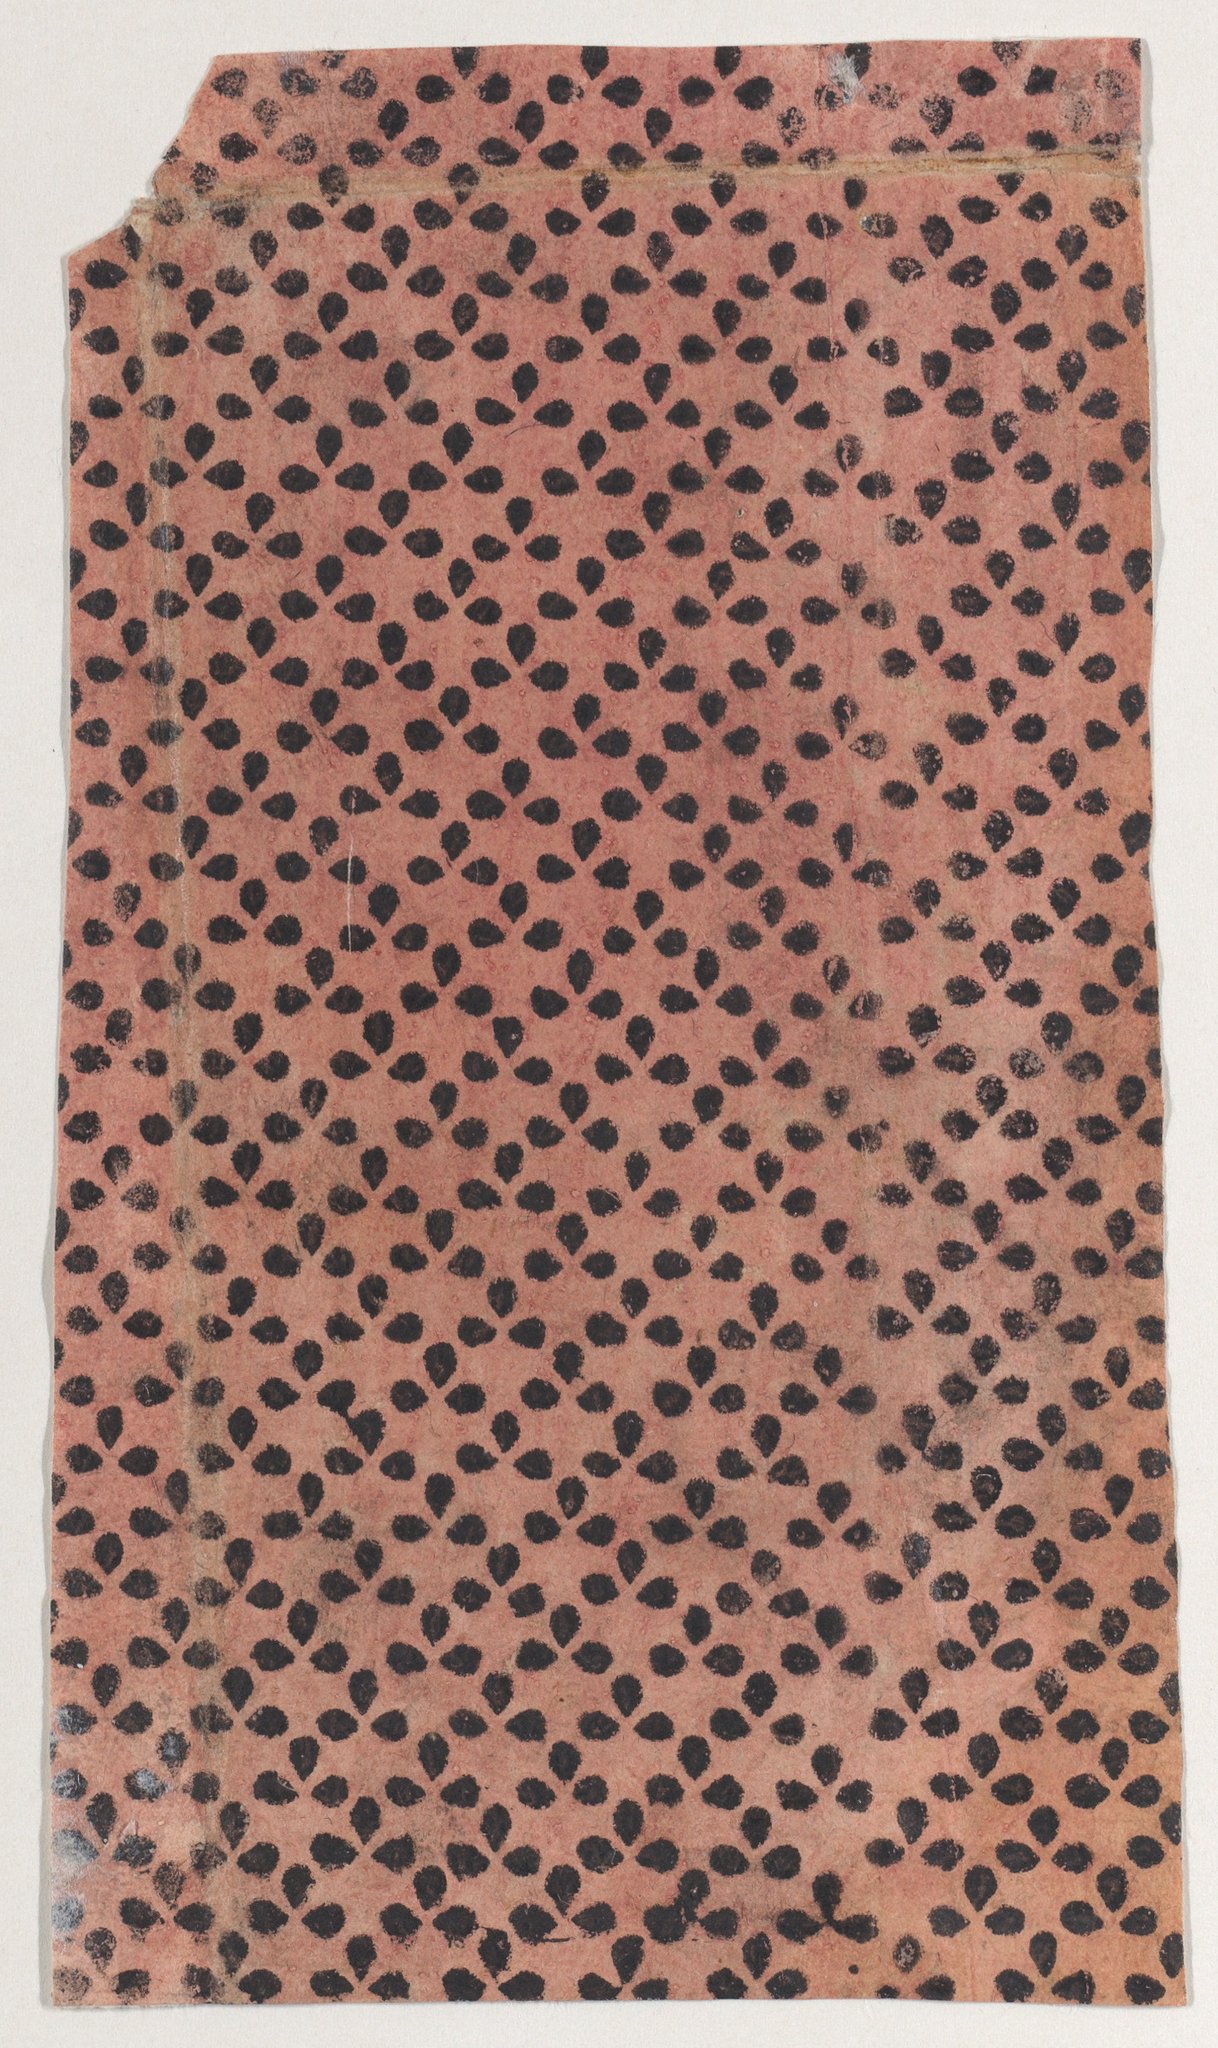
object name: print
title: Sheet with overall pattern of dots in triangular shapes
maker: Anonymous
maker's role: artist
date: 1801-1900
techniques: relief print